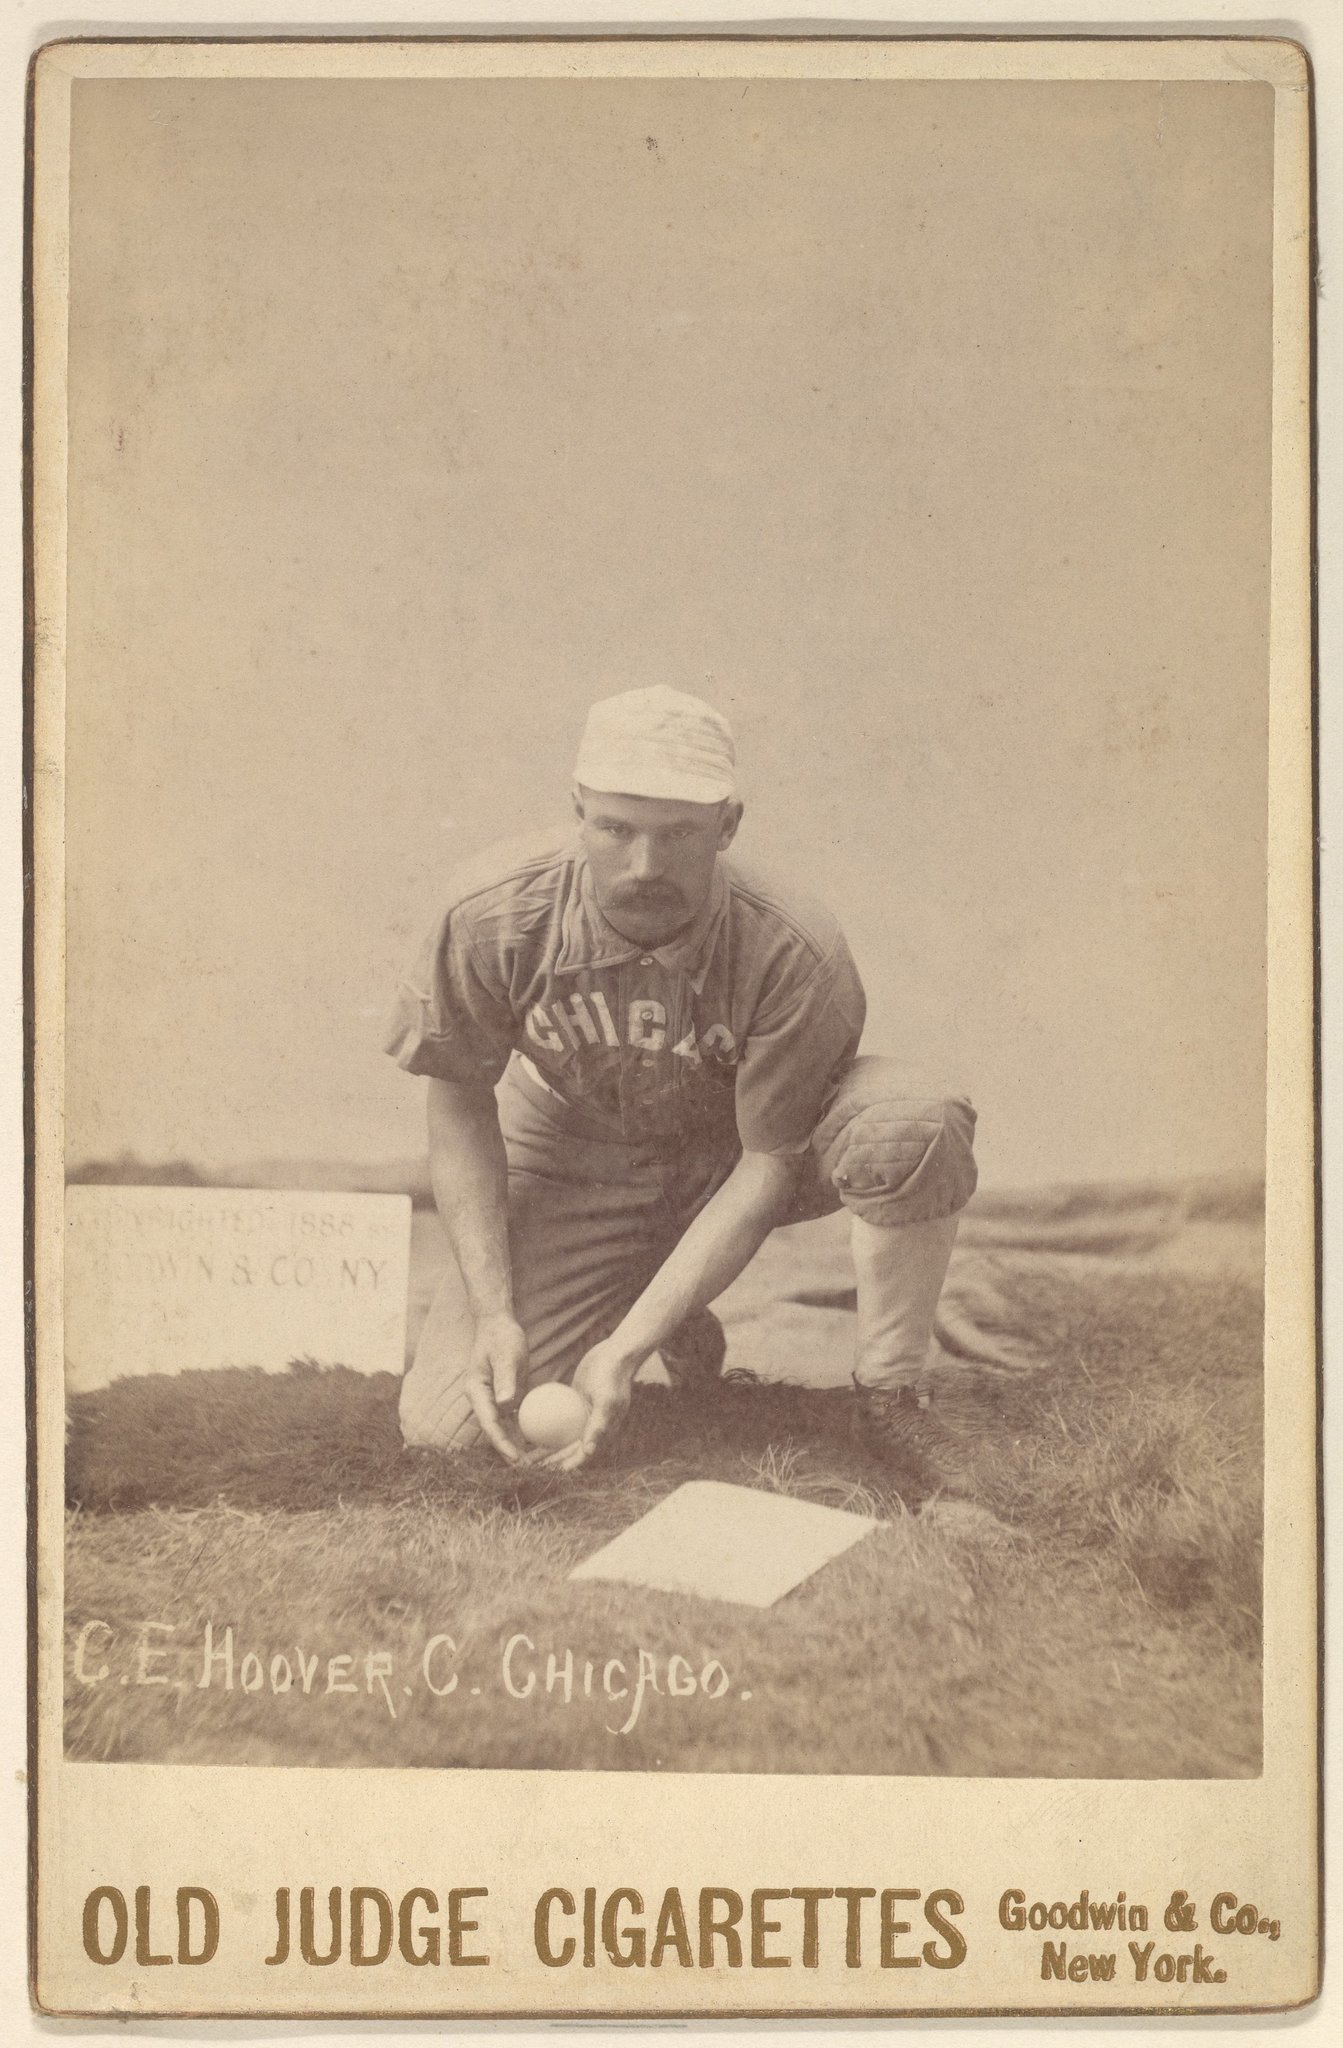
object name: baseball card, photograph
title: C.E. Hoover, Catcher, Chicago, from the series Old Judge Cigarettes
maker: goodwin & company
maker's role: publisher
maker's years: 1850-1950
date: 1888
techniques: albumen silver print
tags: men,portraits,baseball,athletes